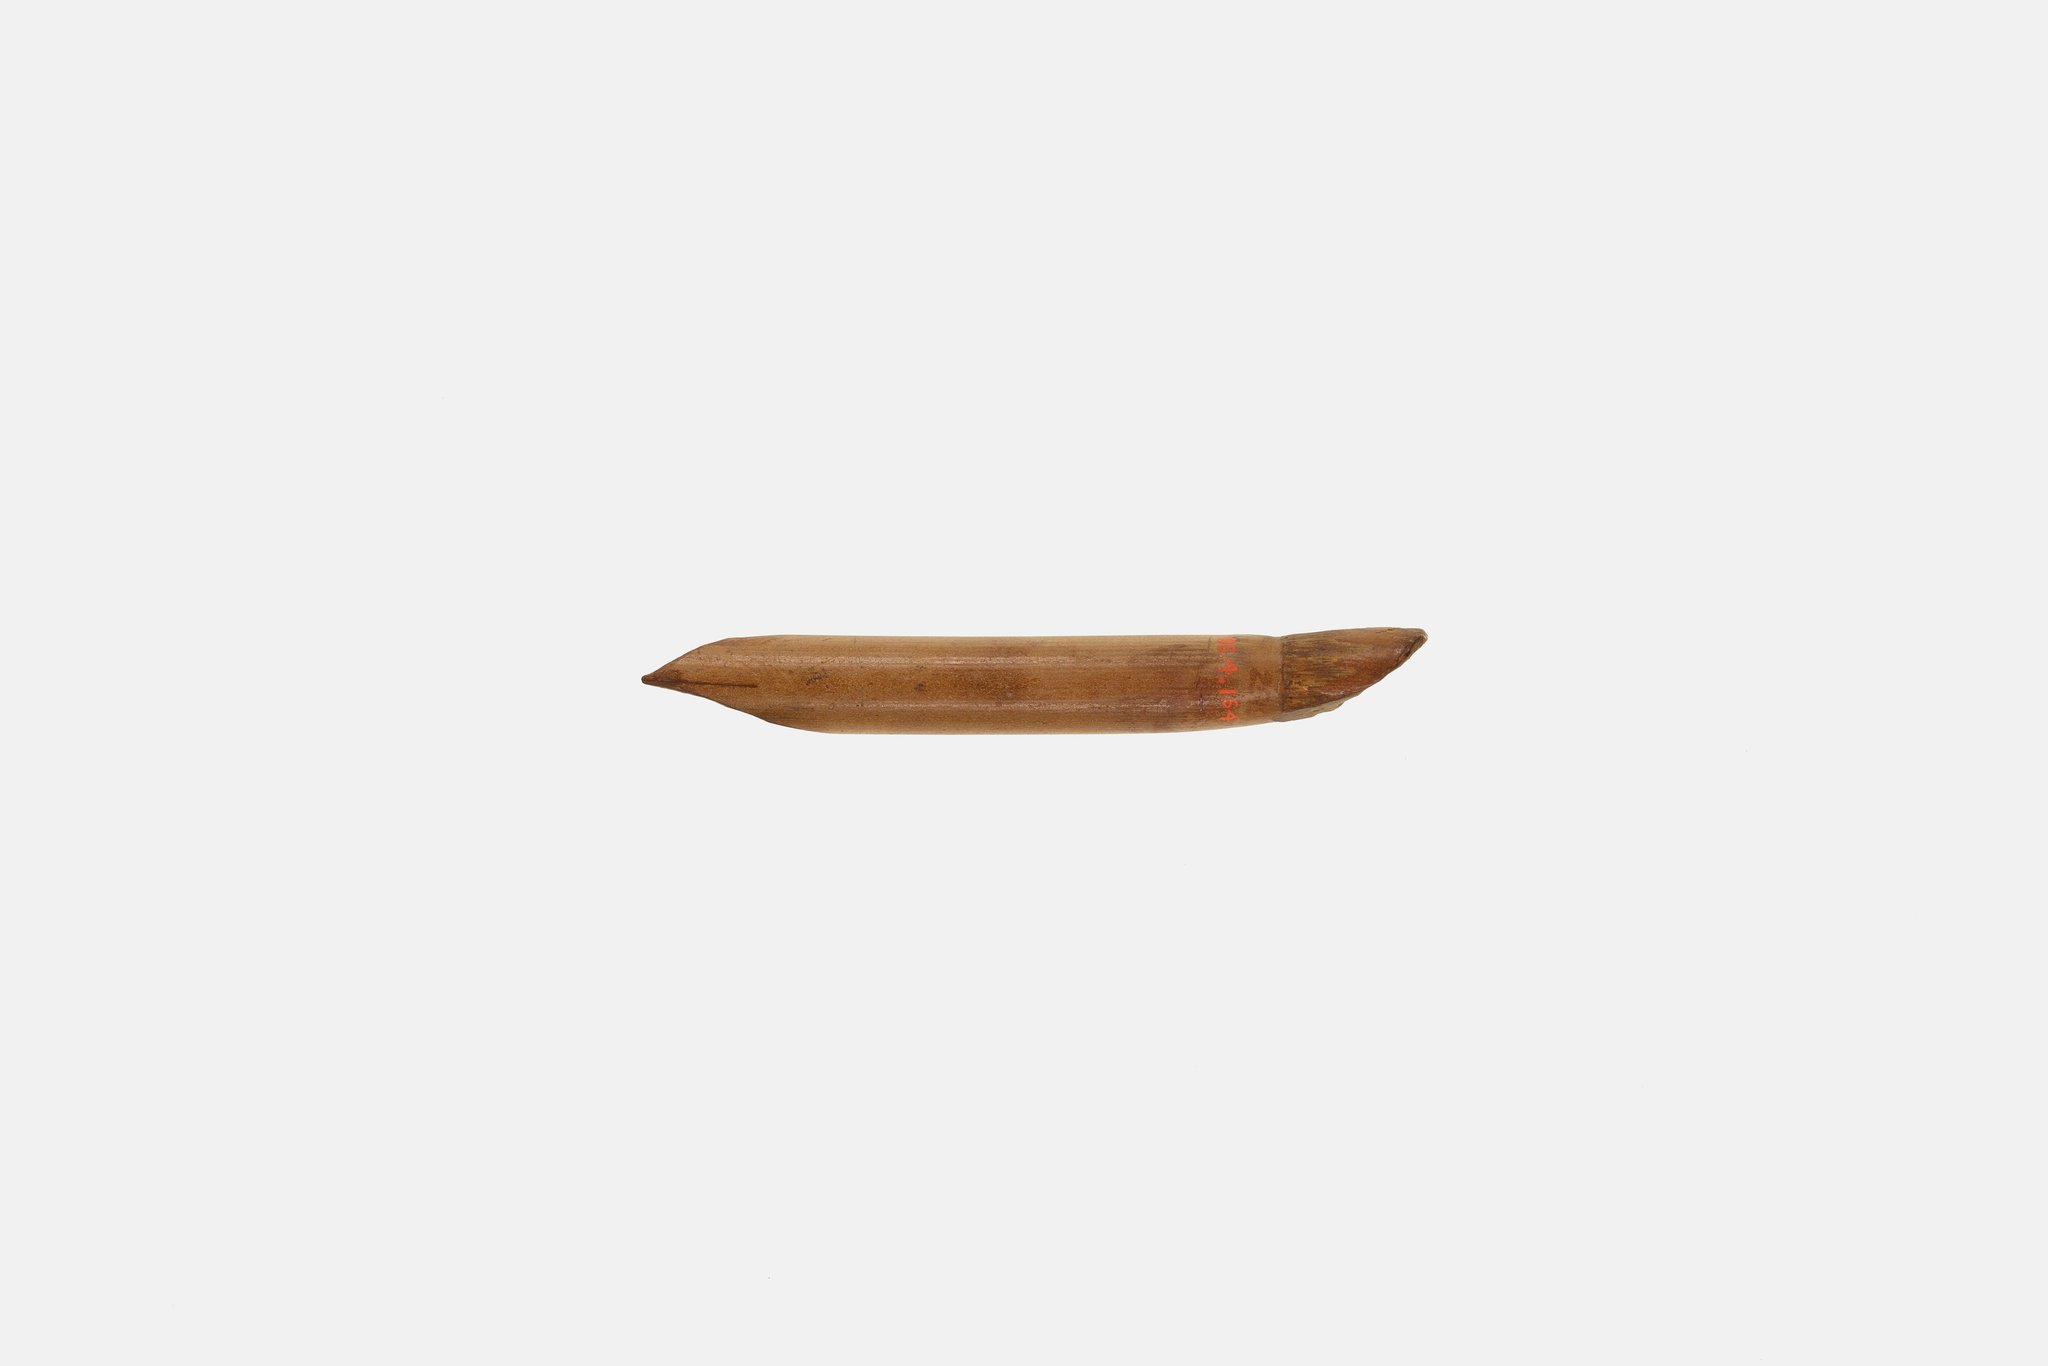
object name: pen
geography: egypt